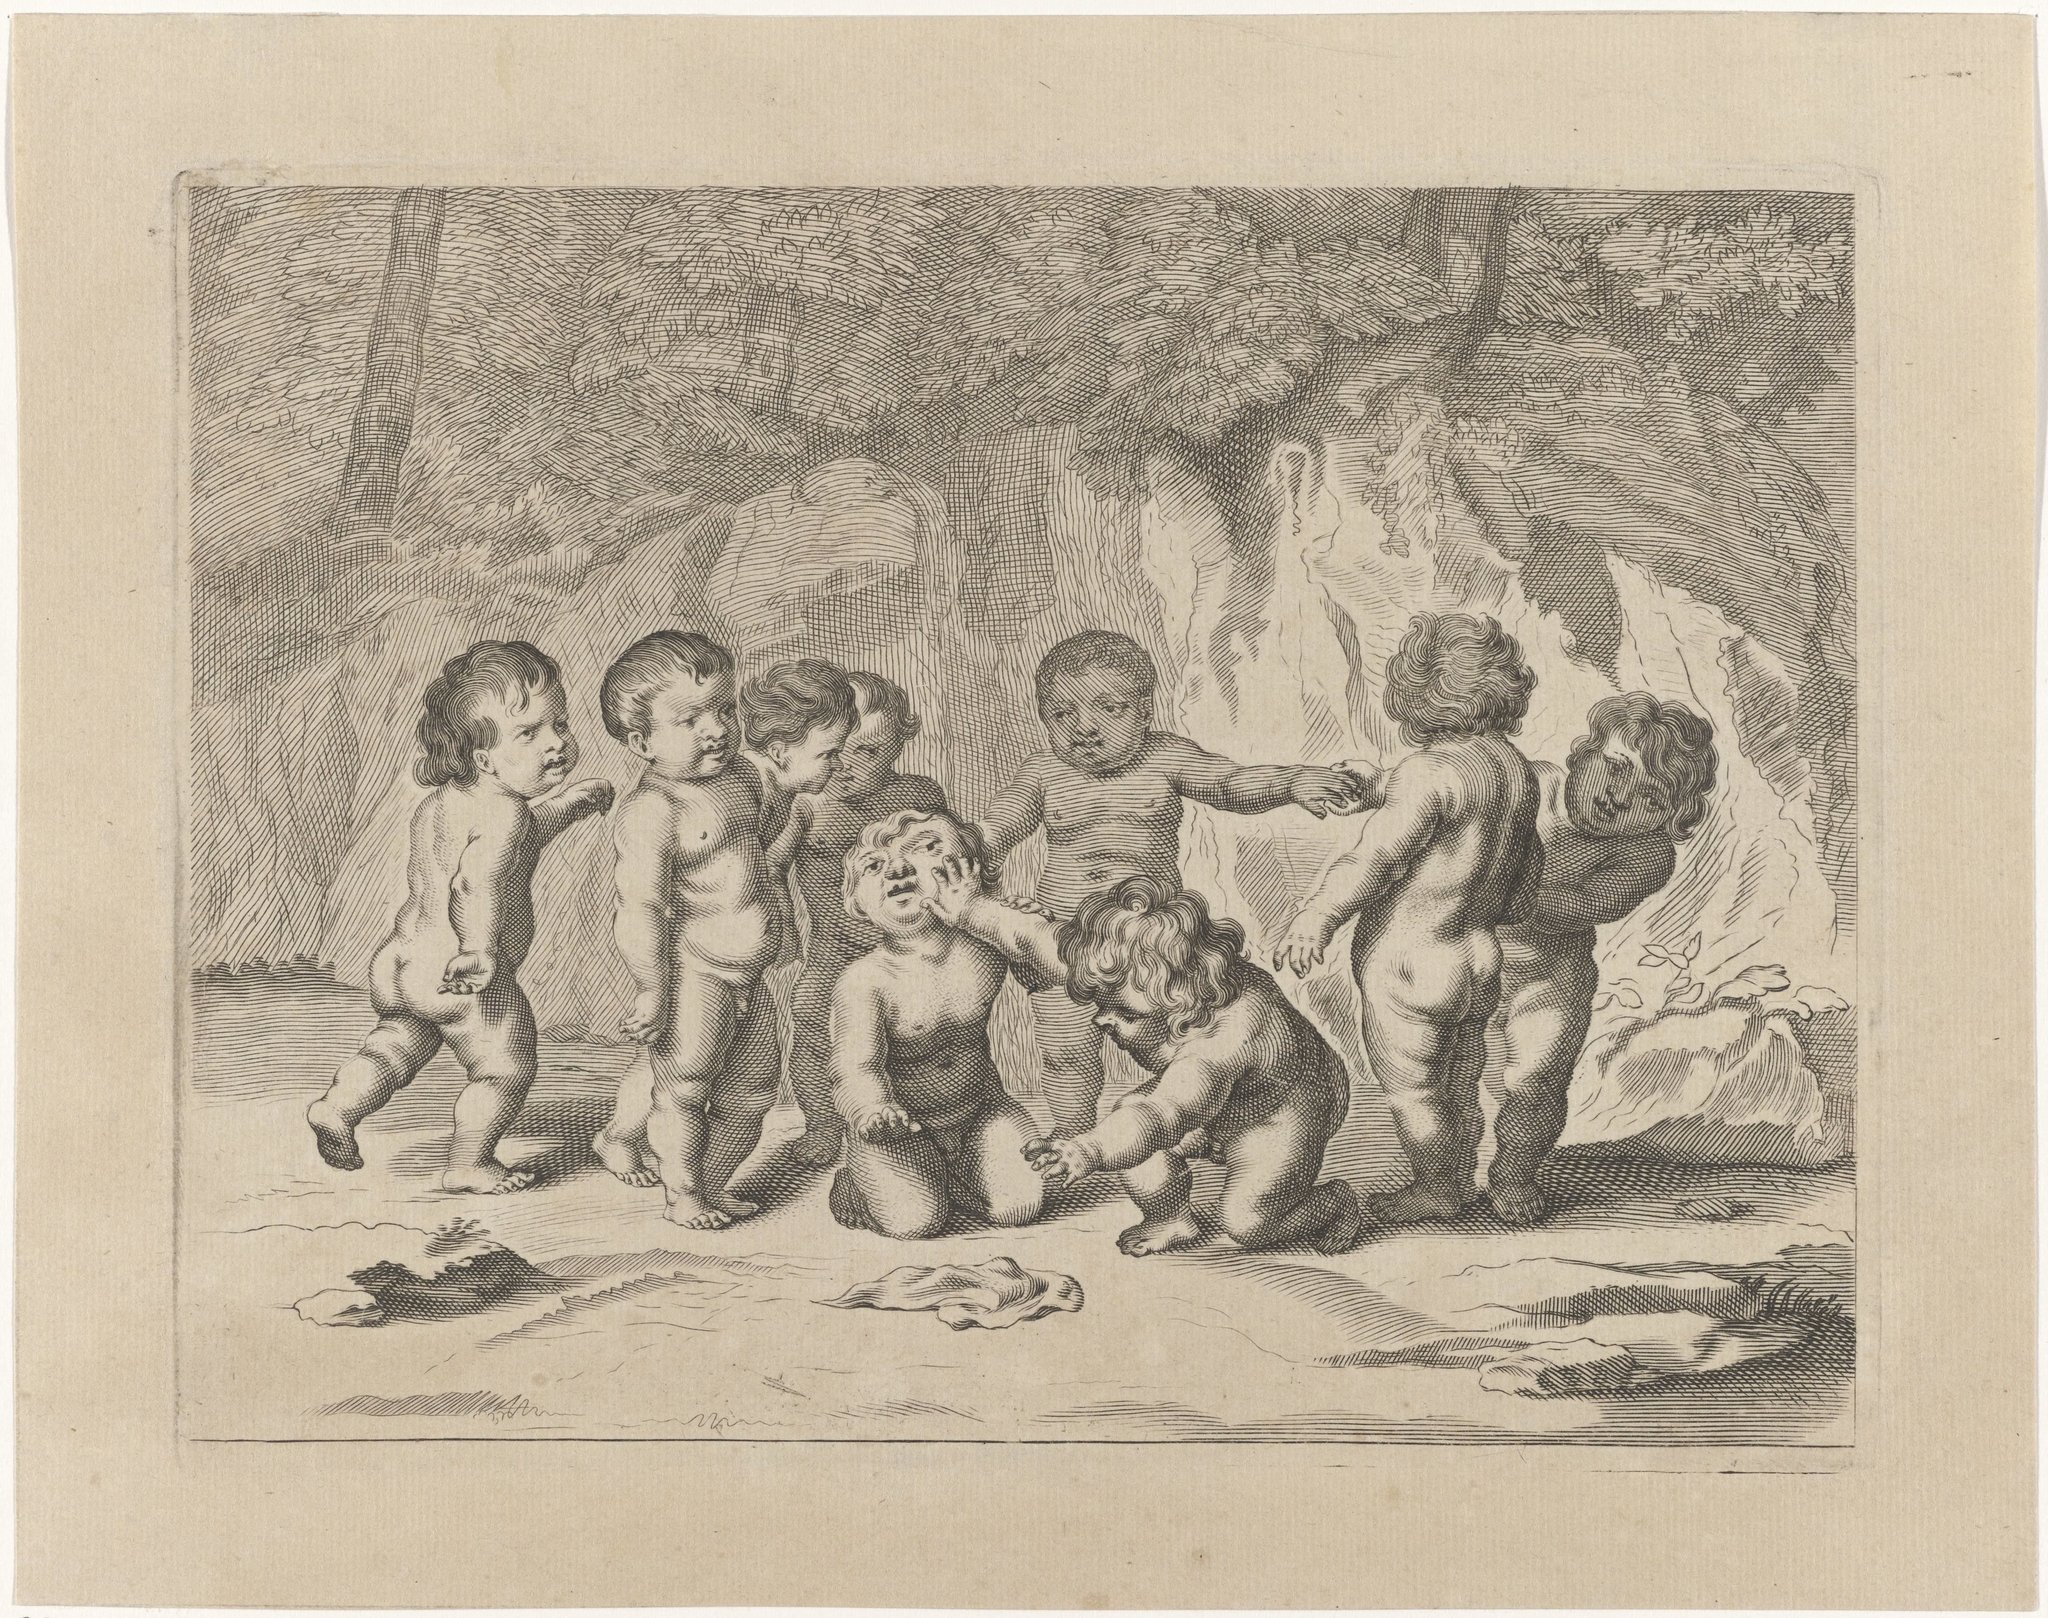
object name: print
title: Putti spelend met een zakdoek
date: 1645-1701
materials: paper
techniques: engraving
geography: amsterdam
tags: games using special objects (marbles, top, hoop, etc.), cupids: 'amores', 'amoretti', 'putti'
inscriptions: collector's mark: Lugt 2228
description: Een groep spelende putti in een landschap. Een van de putti pakt een zakdoek van de grond, terwijl deze een ander wegduwt.